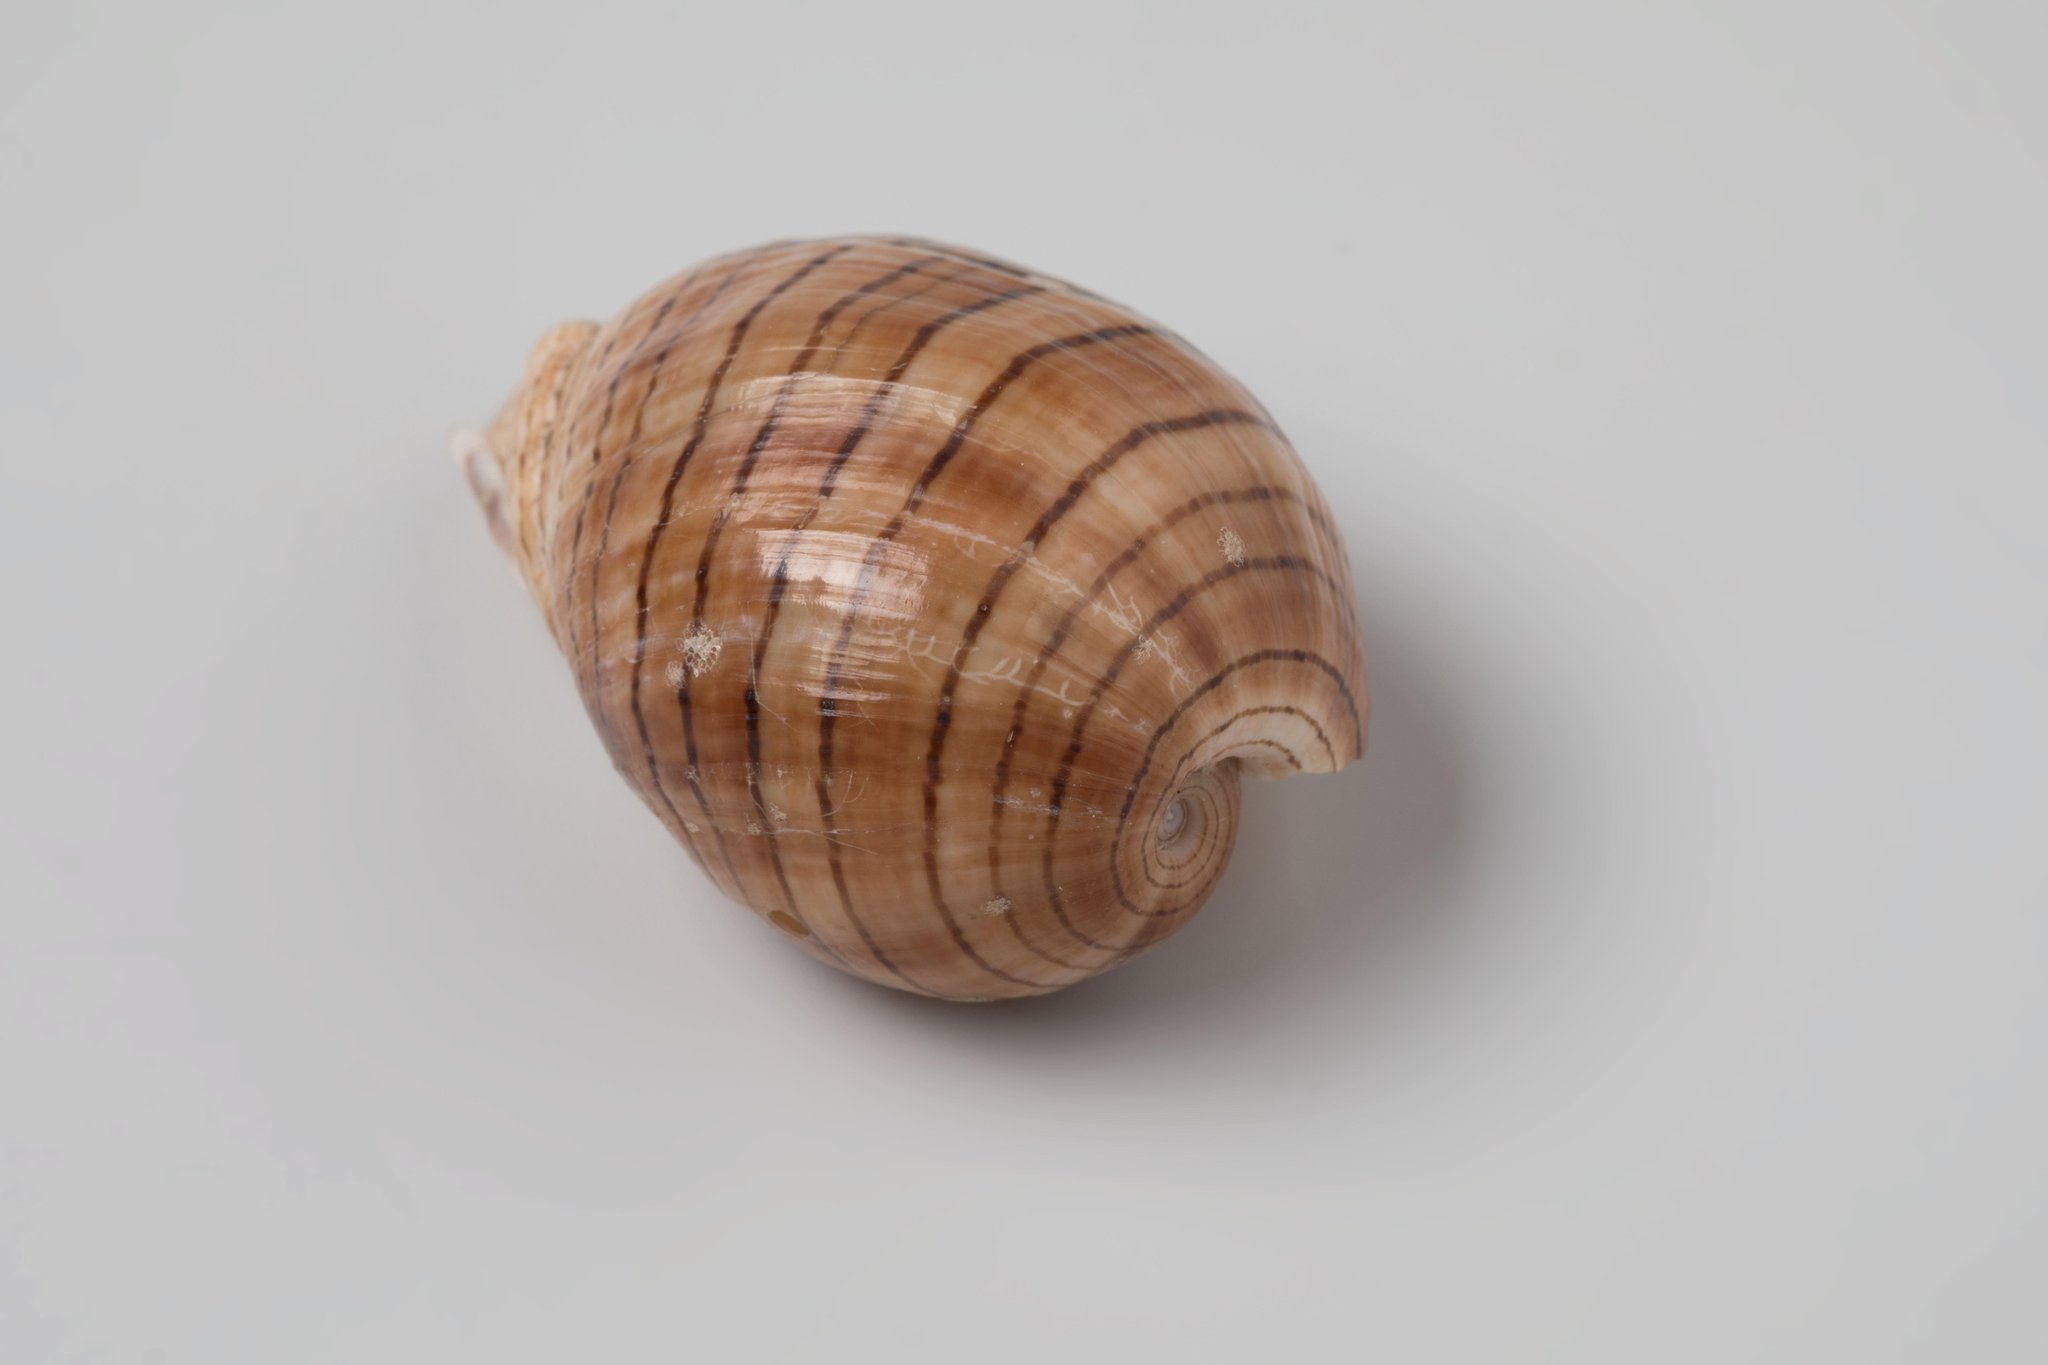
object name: hydatina physis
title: Hydatina physis shell from the wreck of the Dutch East India ship Witte Leeuw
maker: niet van toepassing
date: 1613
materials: shell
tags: verenigde oostindische compagnie, sint-helena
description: Schelp uit V.O.C.-schip de 'Witte Leeuw'.